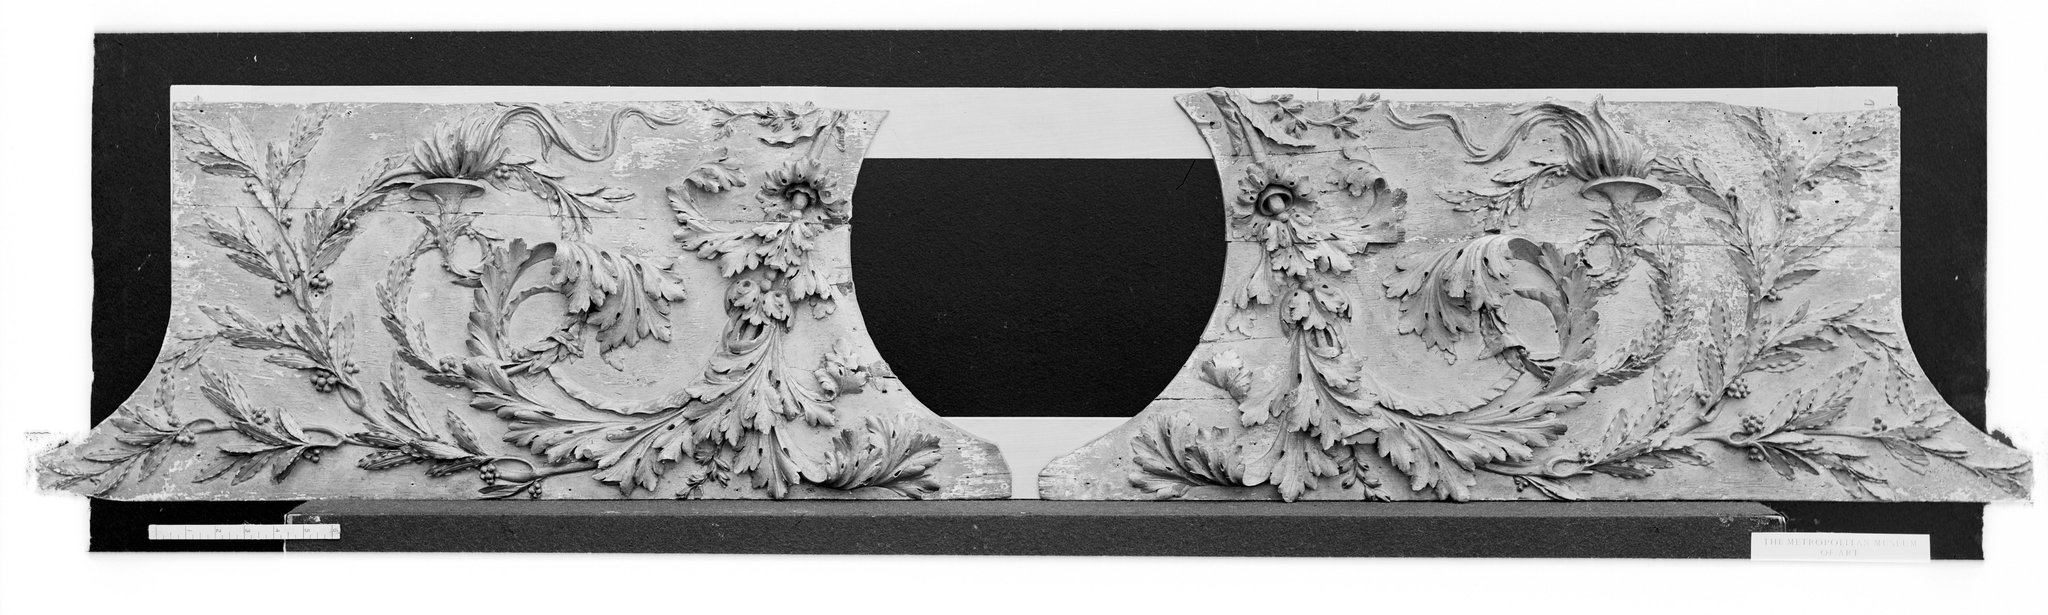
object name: overdoor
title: Overdoor (Dessus de porte)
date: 1701-1800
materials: gilt, wood